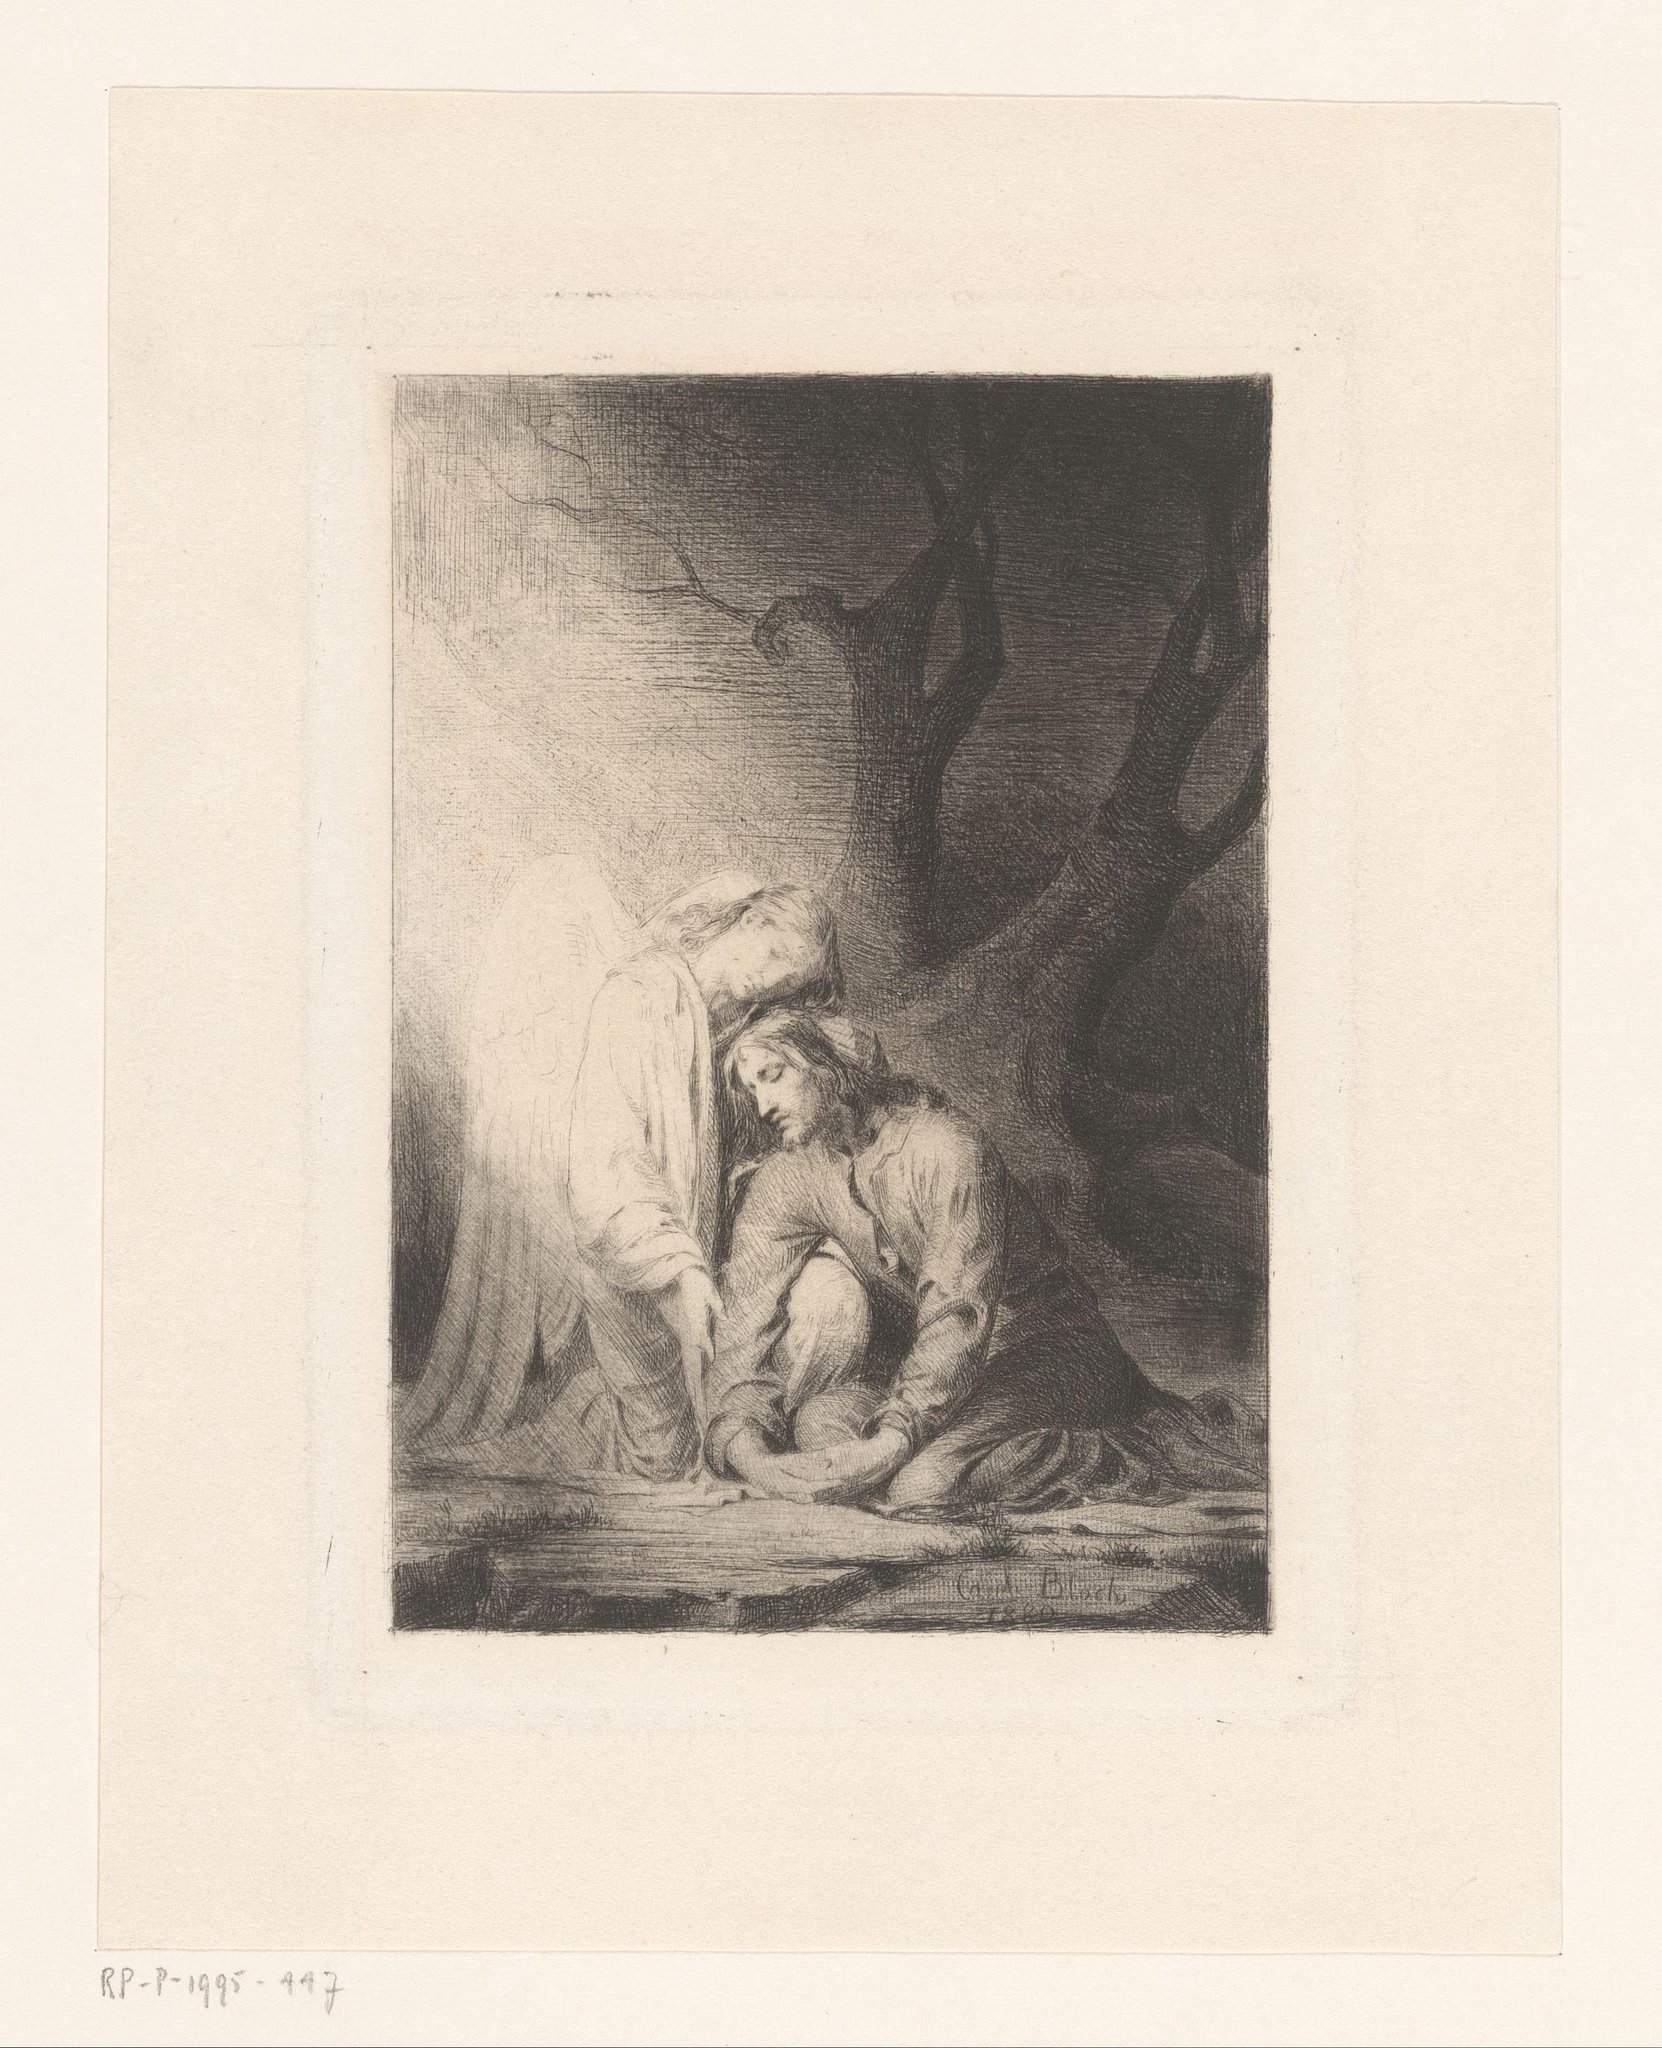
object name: print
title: Christus getroost door een engel in de hof van Getsemane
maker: carl bloch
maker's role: print maker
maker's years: 1834-1890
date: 1880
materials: paper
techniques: drypoint, etching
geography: scandinavia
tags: agony of christ: to comfort him one or more angels appear to christ with chalice and/or cross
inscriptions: signature and date: ‘r.o. gesigneerd en gedateerd Carl Bloch 1880’, collector's mark: Lugt 2228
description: Christus zit geknield met gesloten ogen voor een boom. Hij wordt getroost door een engel.